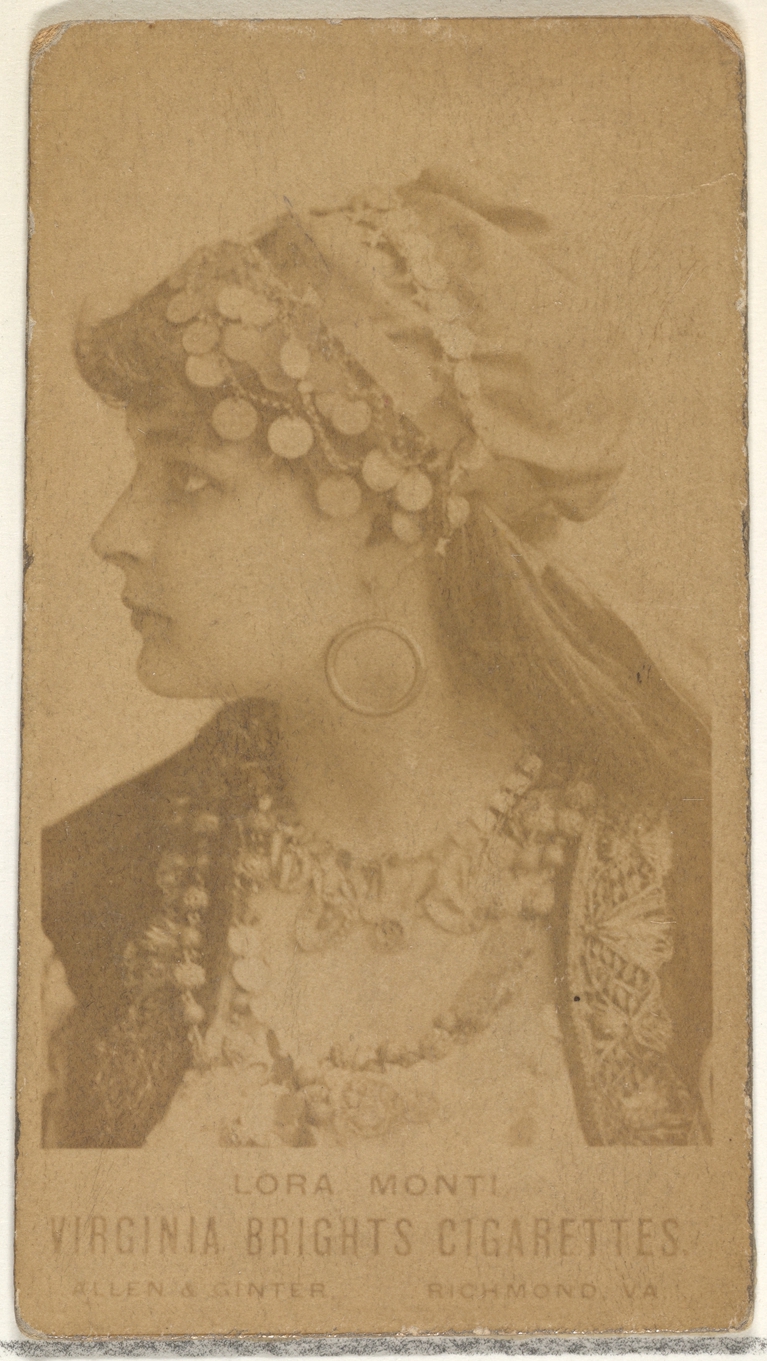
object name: photograph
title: Lora Monti, from the Actors and Actresses series (N45, Type 1) for Virginia Brights Cigarettes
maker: allen & ginter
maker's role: publisher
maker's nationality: american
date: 1888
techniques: albumen silver print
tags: women,actresses